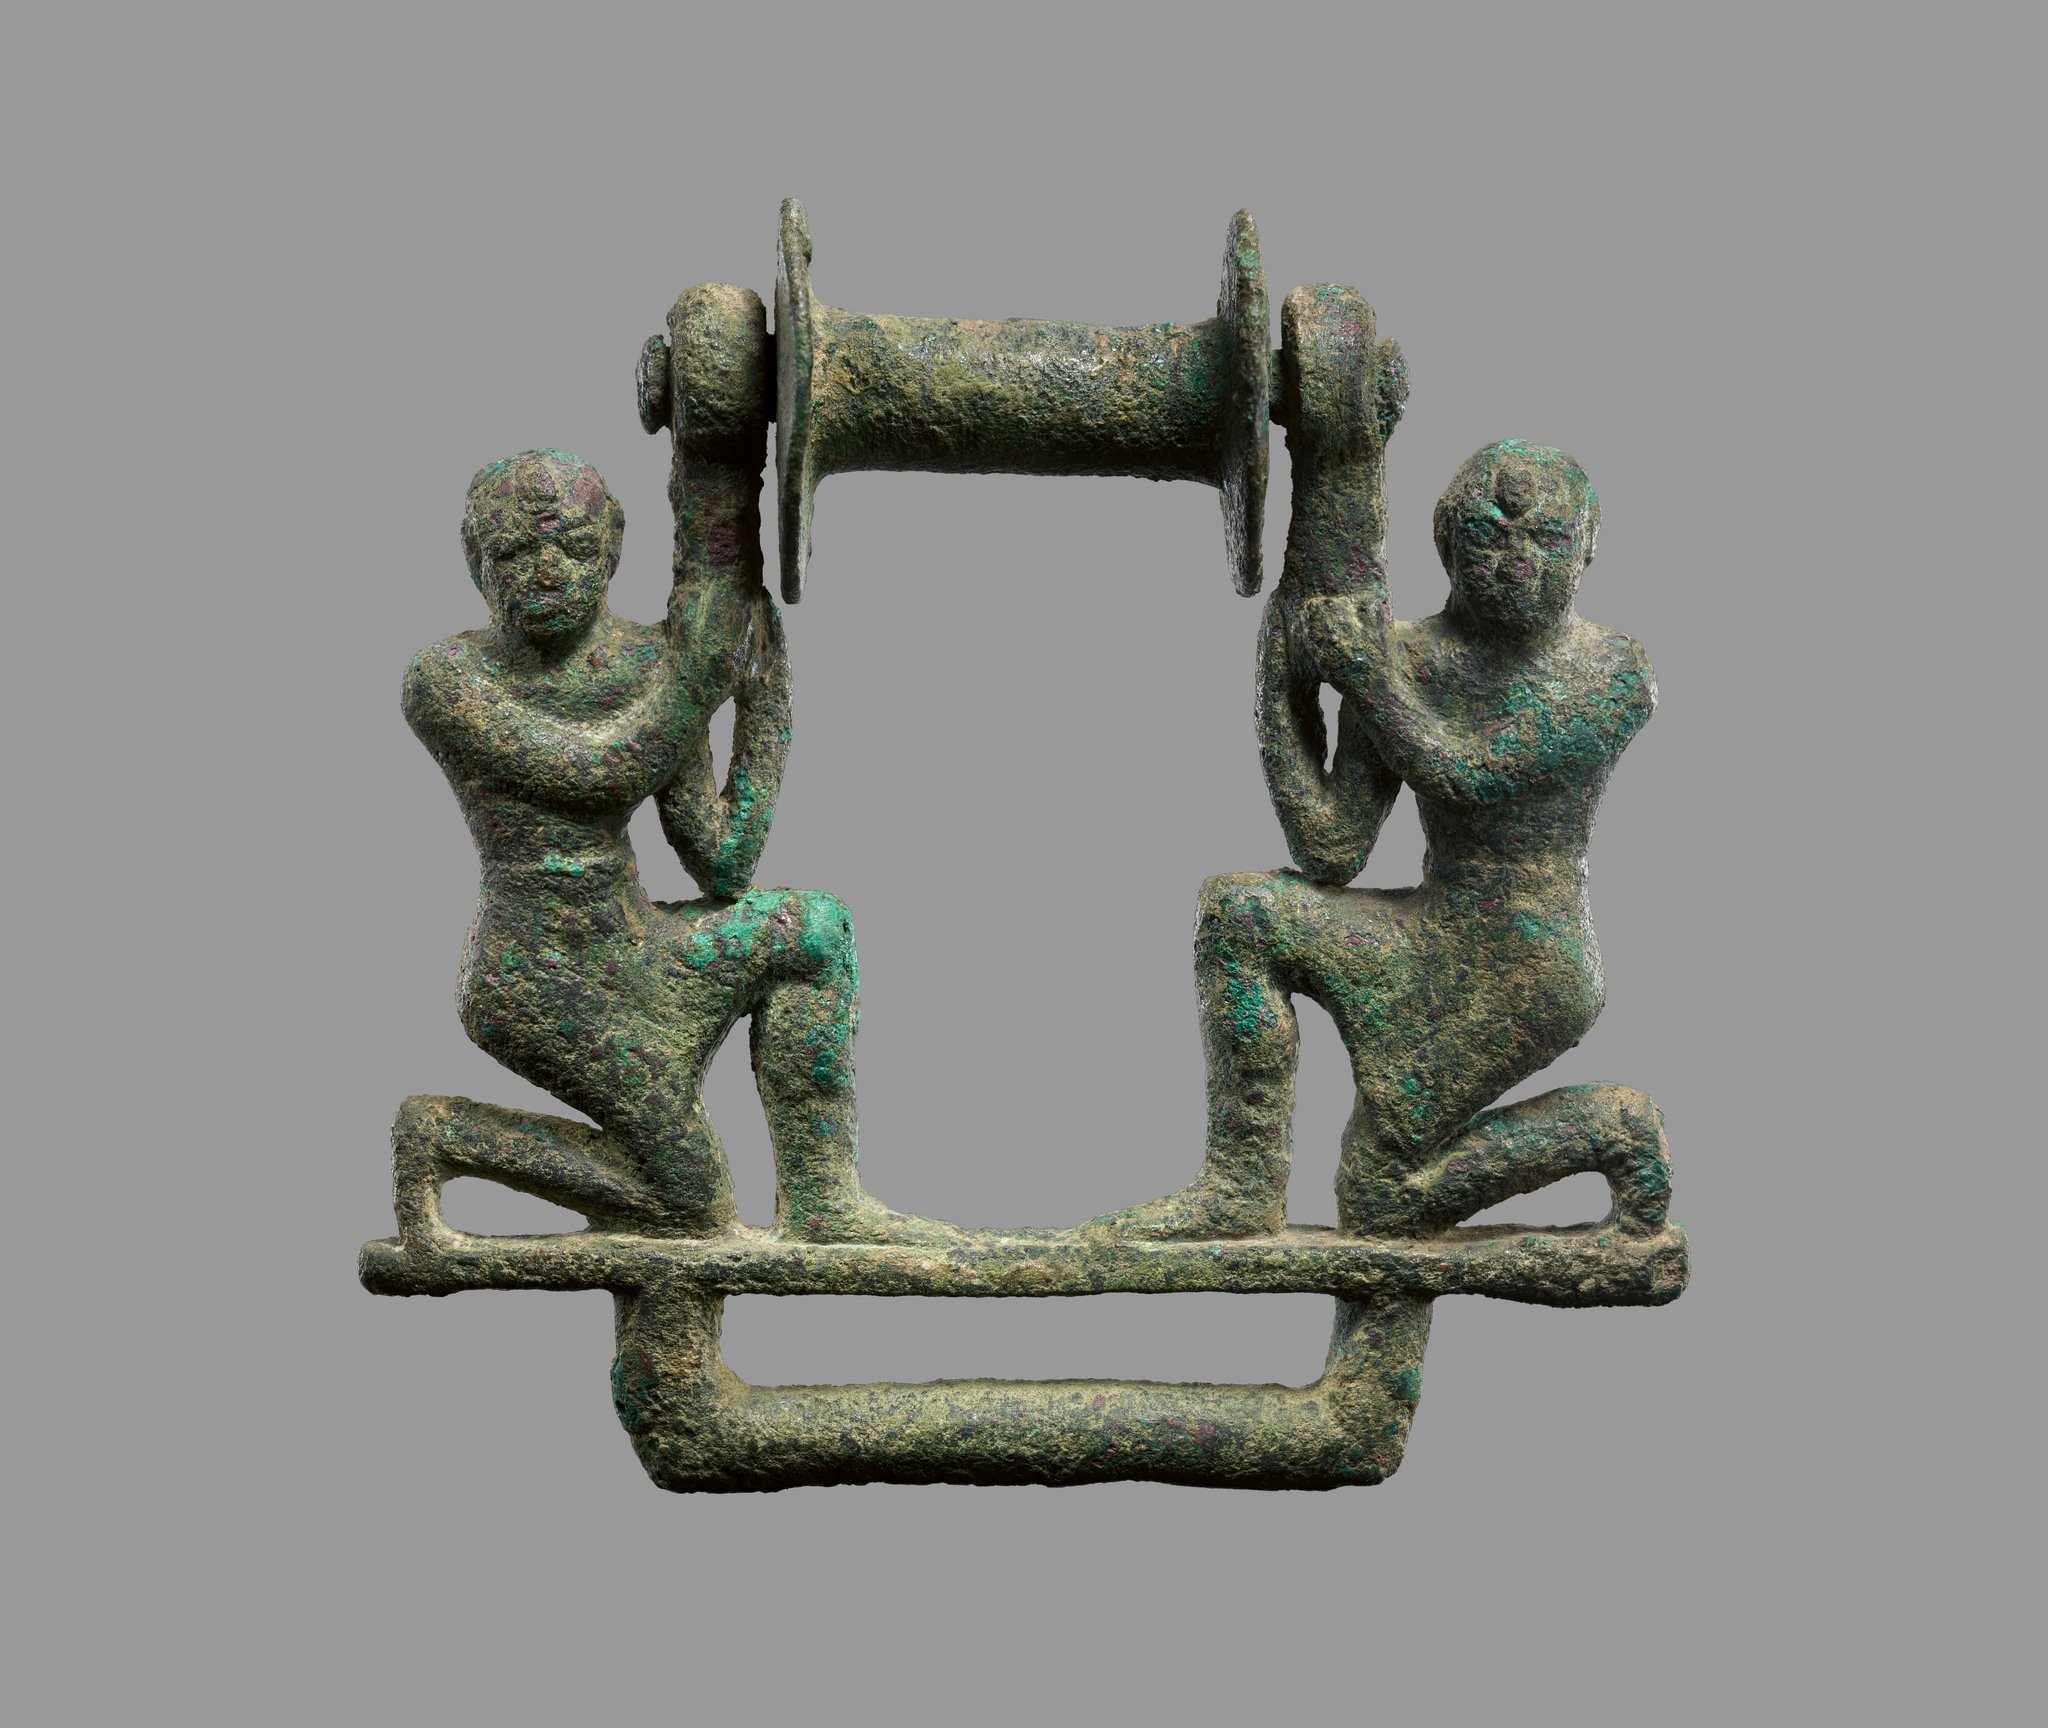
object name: plaque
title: Plaque with two male figures supporting a roller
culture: babylonian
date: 2000-1600 BCE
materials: bronze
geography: mesopotamia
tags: men